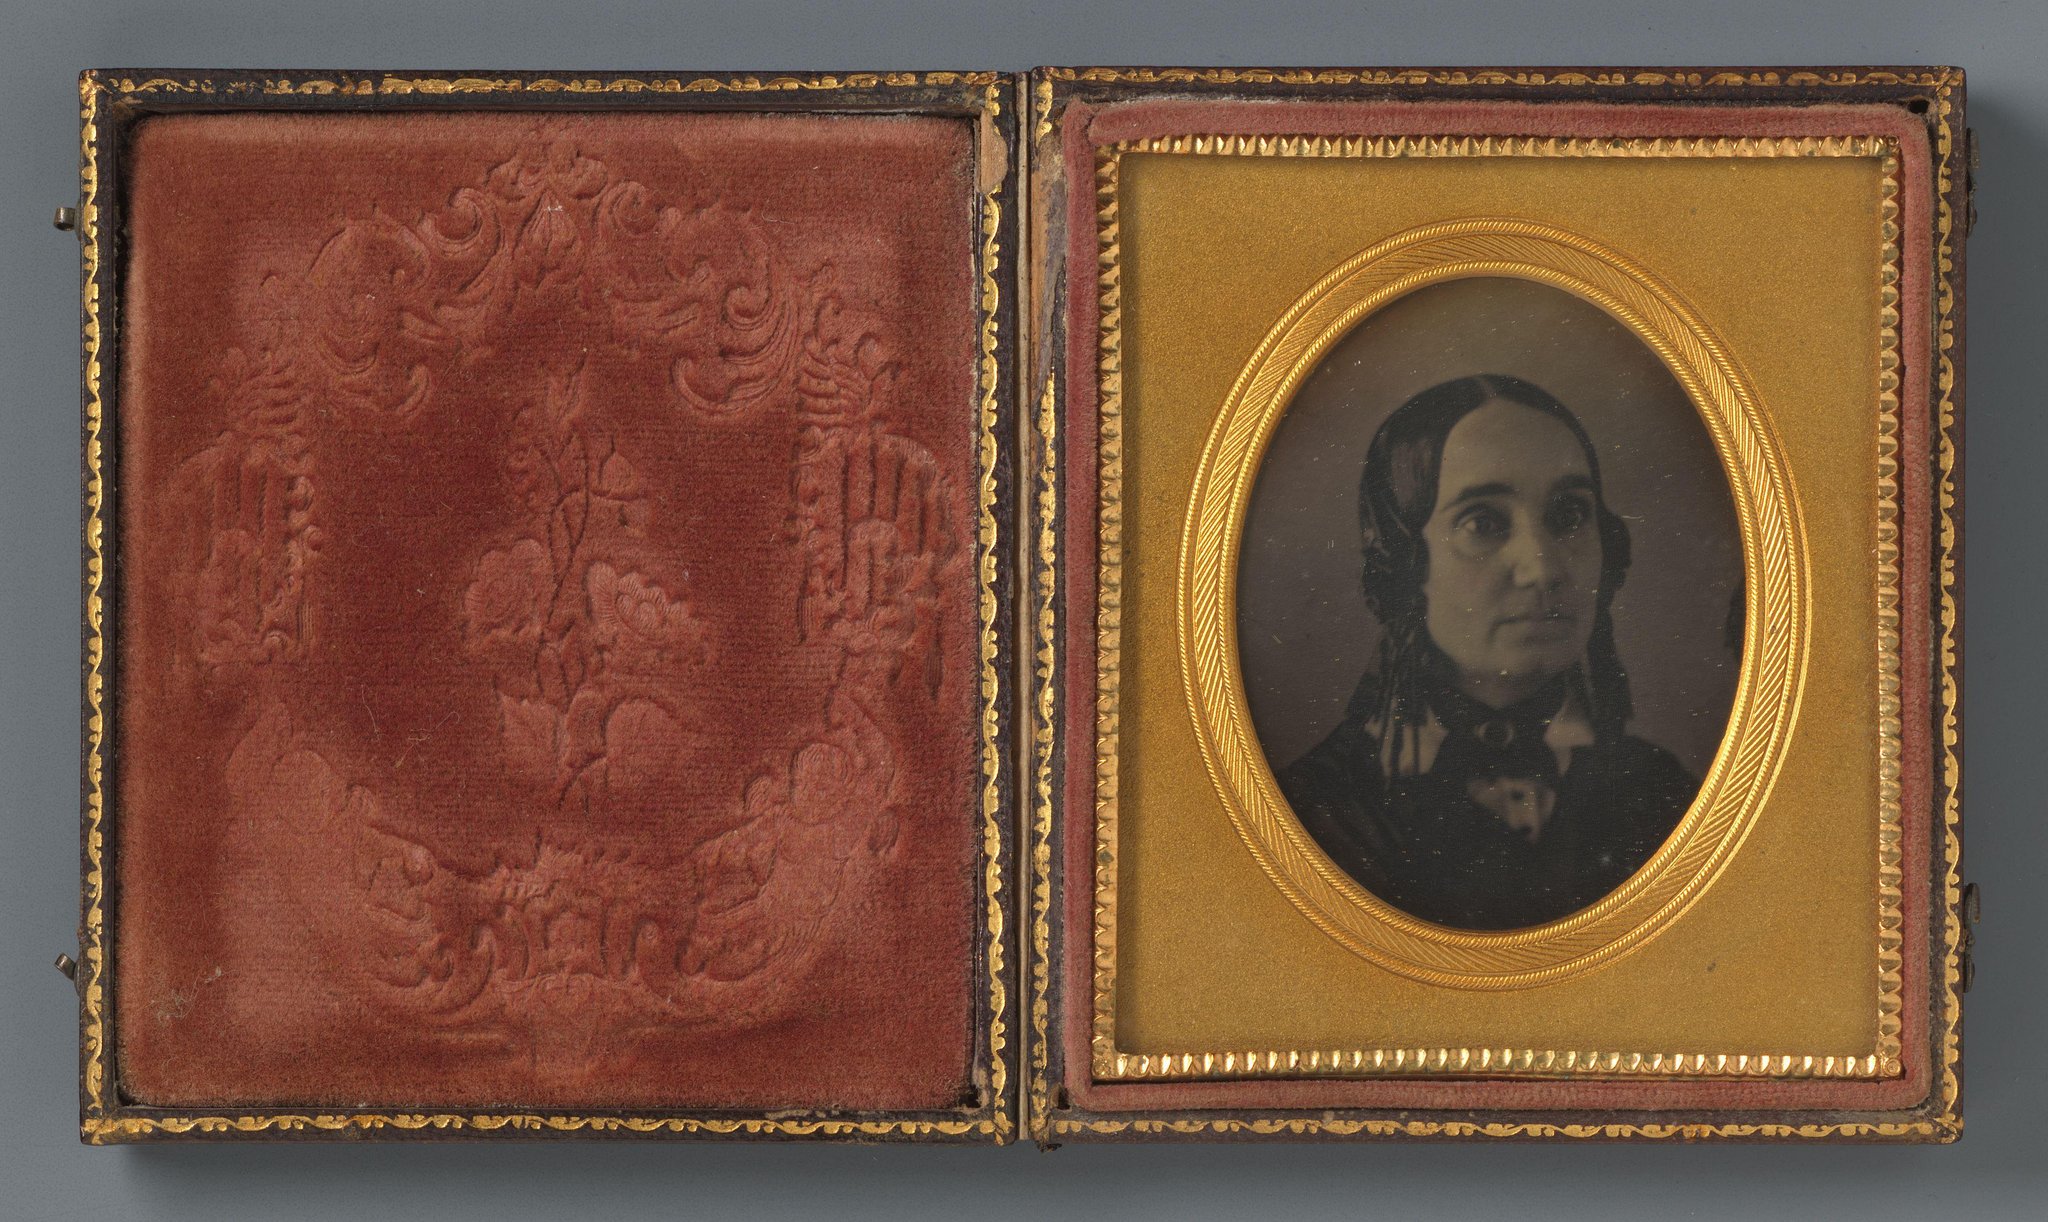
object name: photograph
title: Portret van een onbekende vrouw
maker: Anonymous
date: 1840-1860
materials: copper, glass, leather, velvet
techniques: daguerreotype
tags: adult woman, historical persons